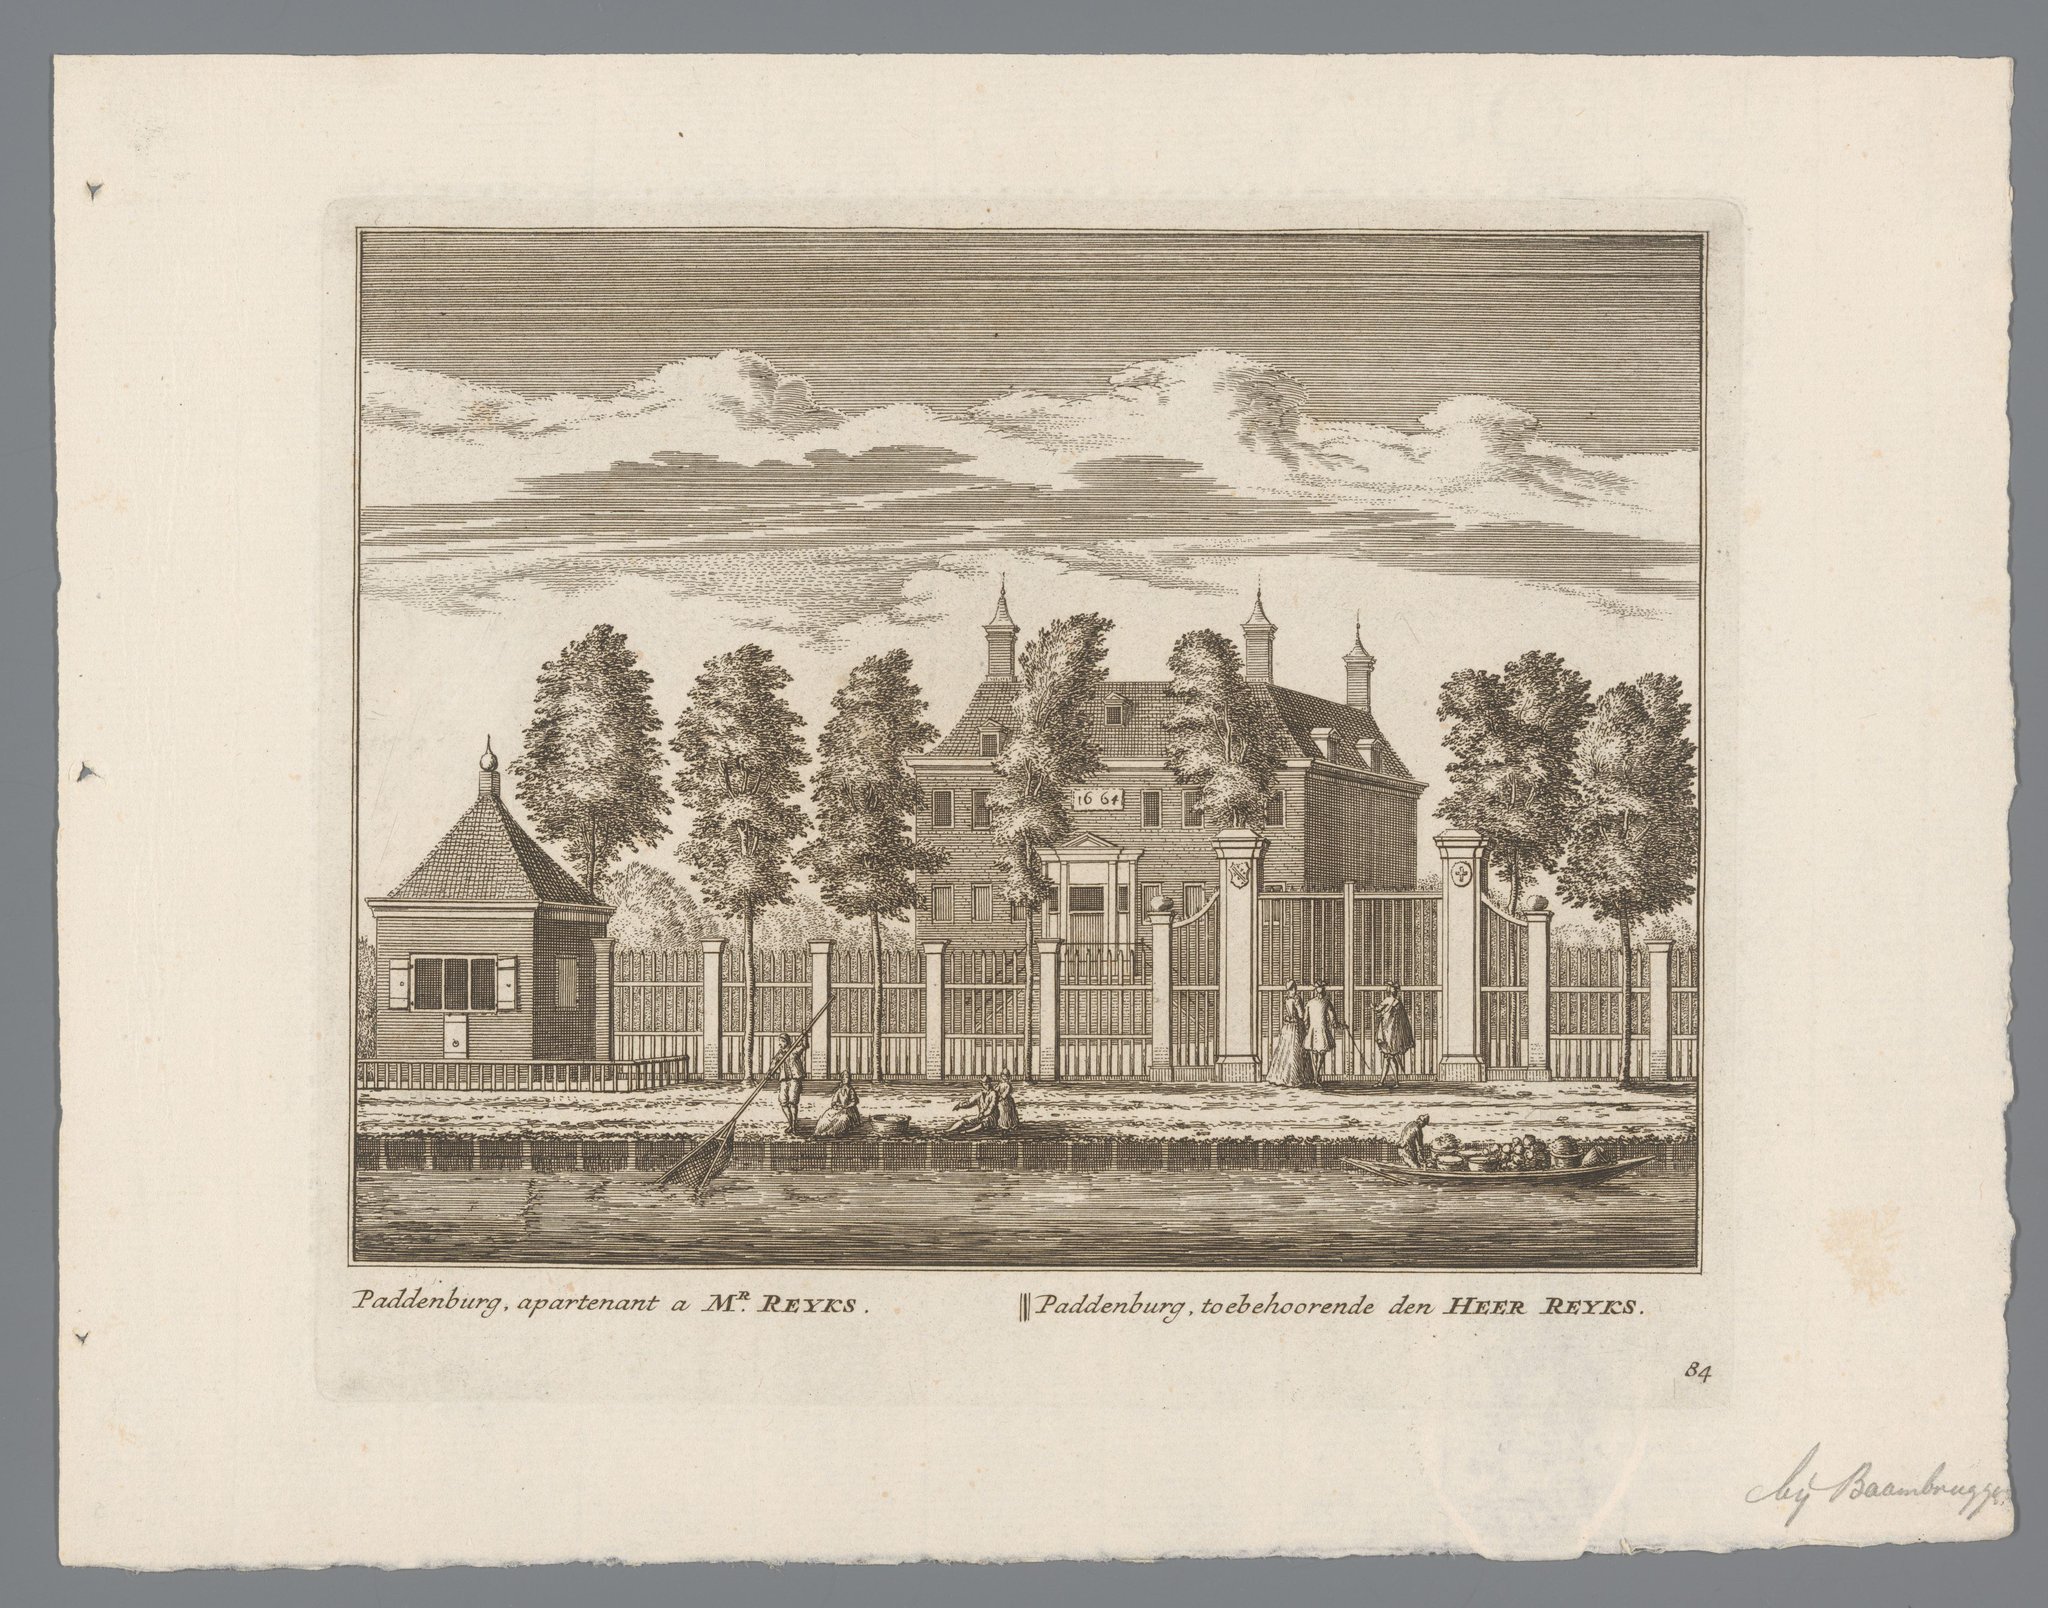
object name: print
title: Paddenburg, apartenant a mr. Reyks / Paddenburg, toebehoorende den heer Reyks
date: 1730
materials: paper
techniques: etching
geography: amsterdam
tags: rural housing, e.g. country-house, villa, cottage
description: Prent uit: Rademaker, Abraham. Hollands Arcadia, of de vermaarde rivier den Amstel (...) / L'Arcadie Hollandoise (...). Amsterdam: Leonard Schenk, 1730.